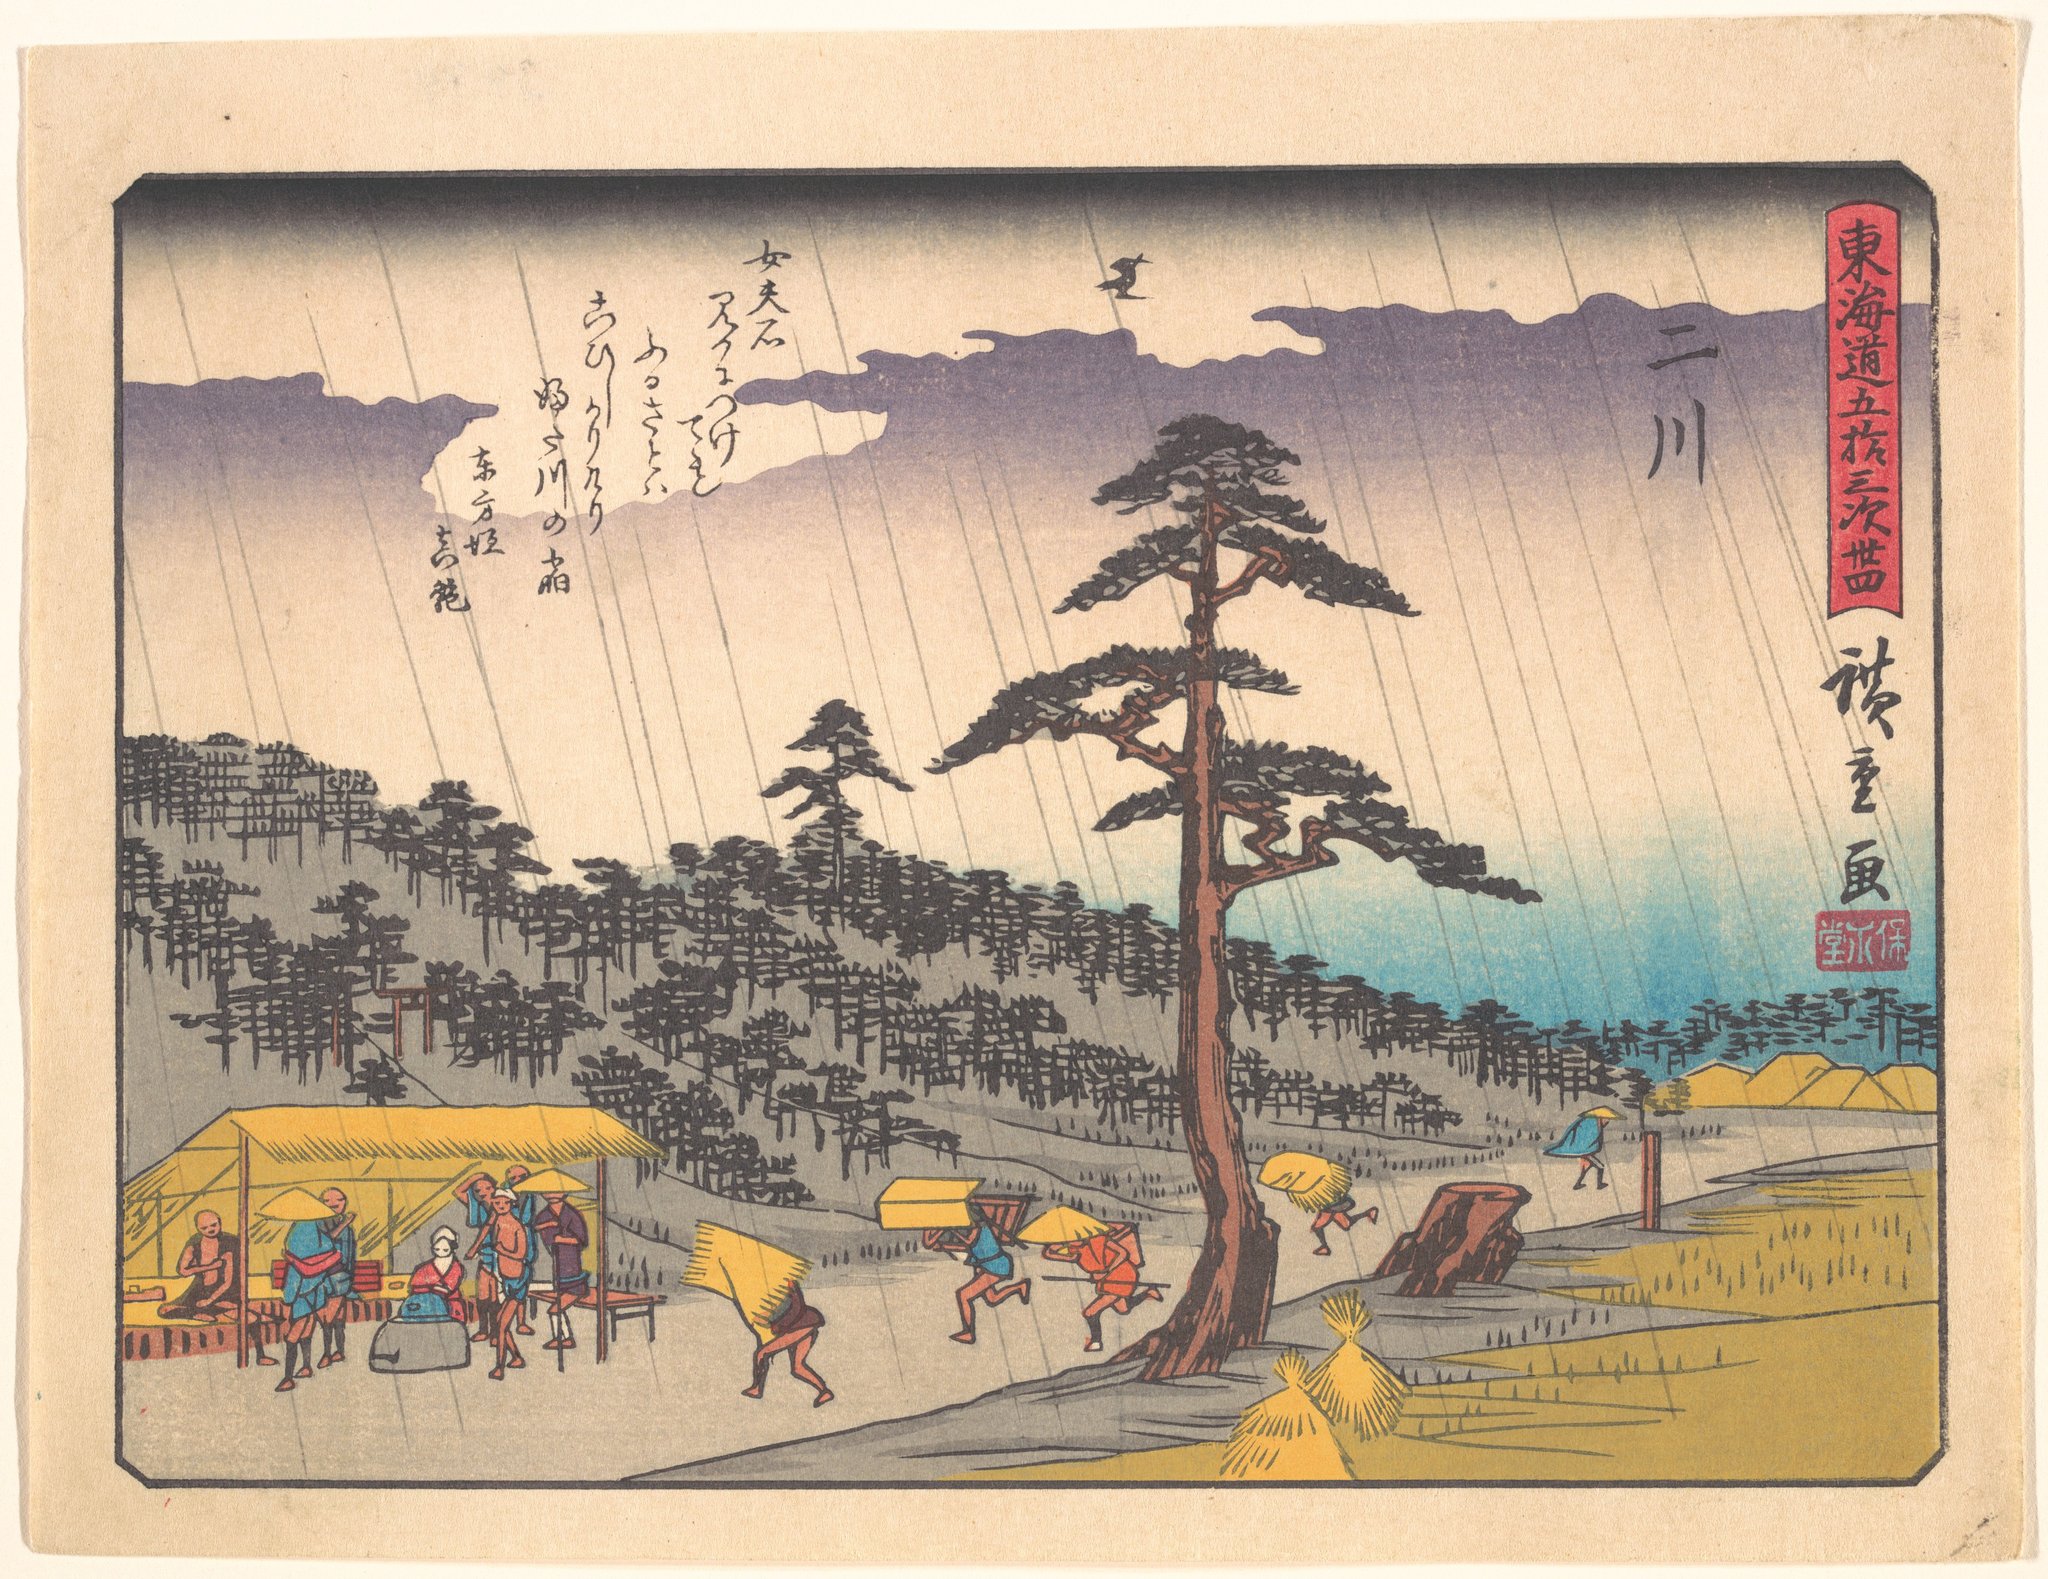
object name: print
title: Futakawa, from the series The Fifty-three Stations of the Tōkaidō Road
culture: japanese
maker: utagawa hiroshige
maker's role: artist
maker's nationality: japanese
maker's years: 1797-1858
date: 1901-1933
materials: ink, paper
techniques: woodblock print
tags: men,landscapes,rain